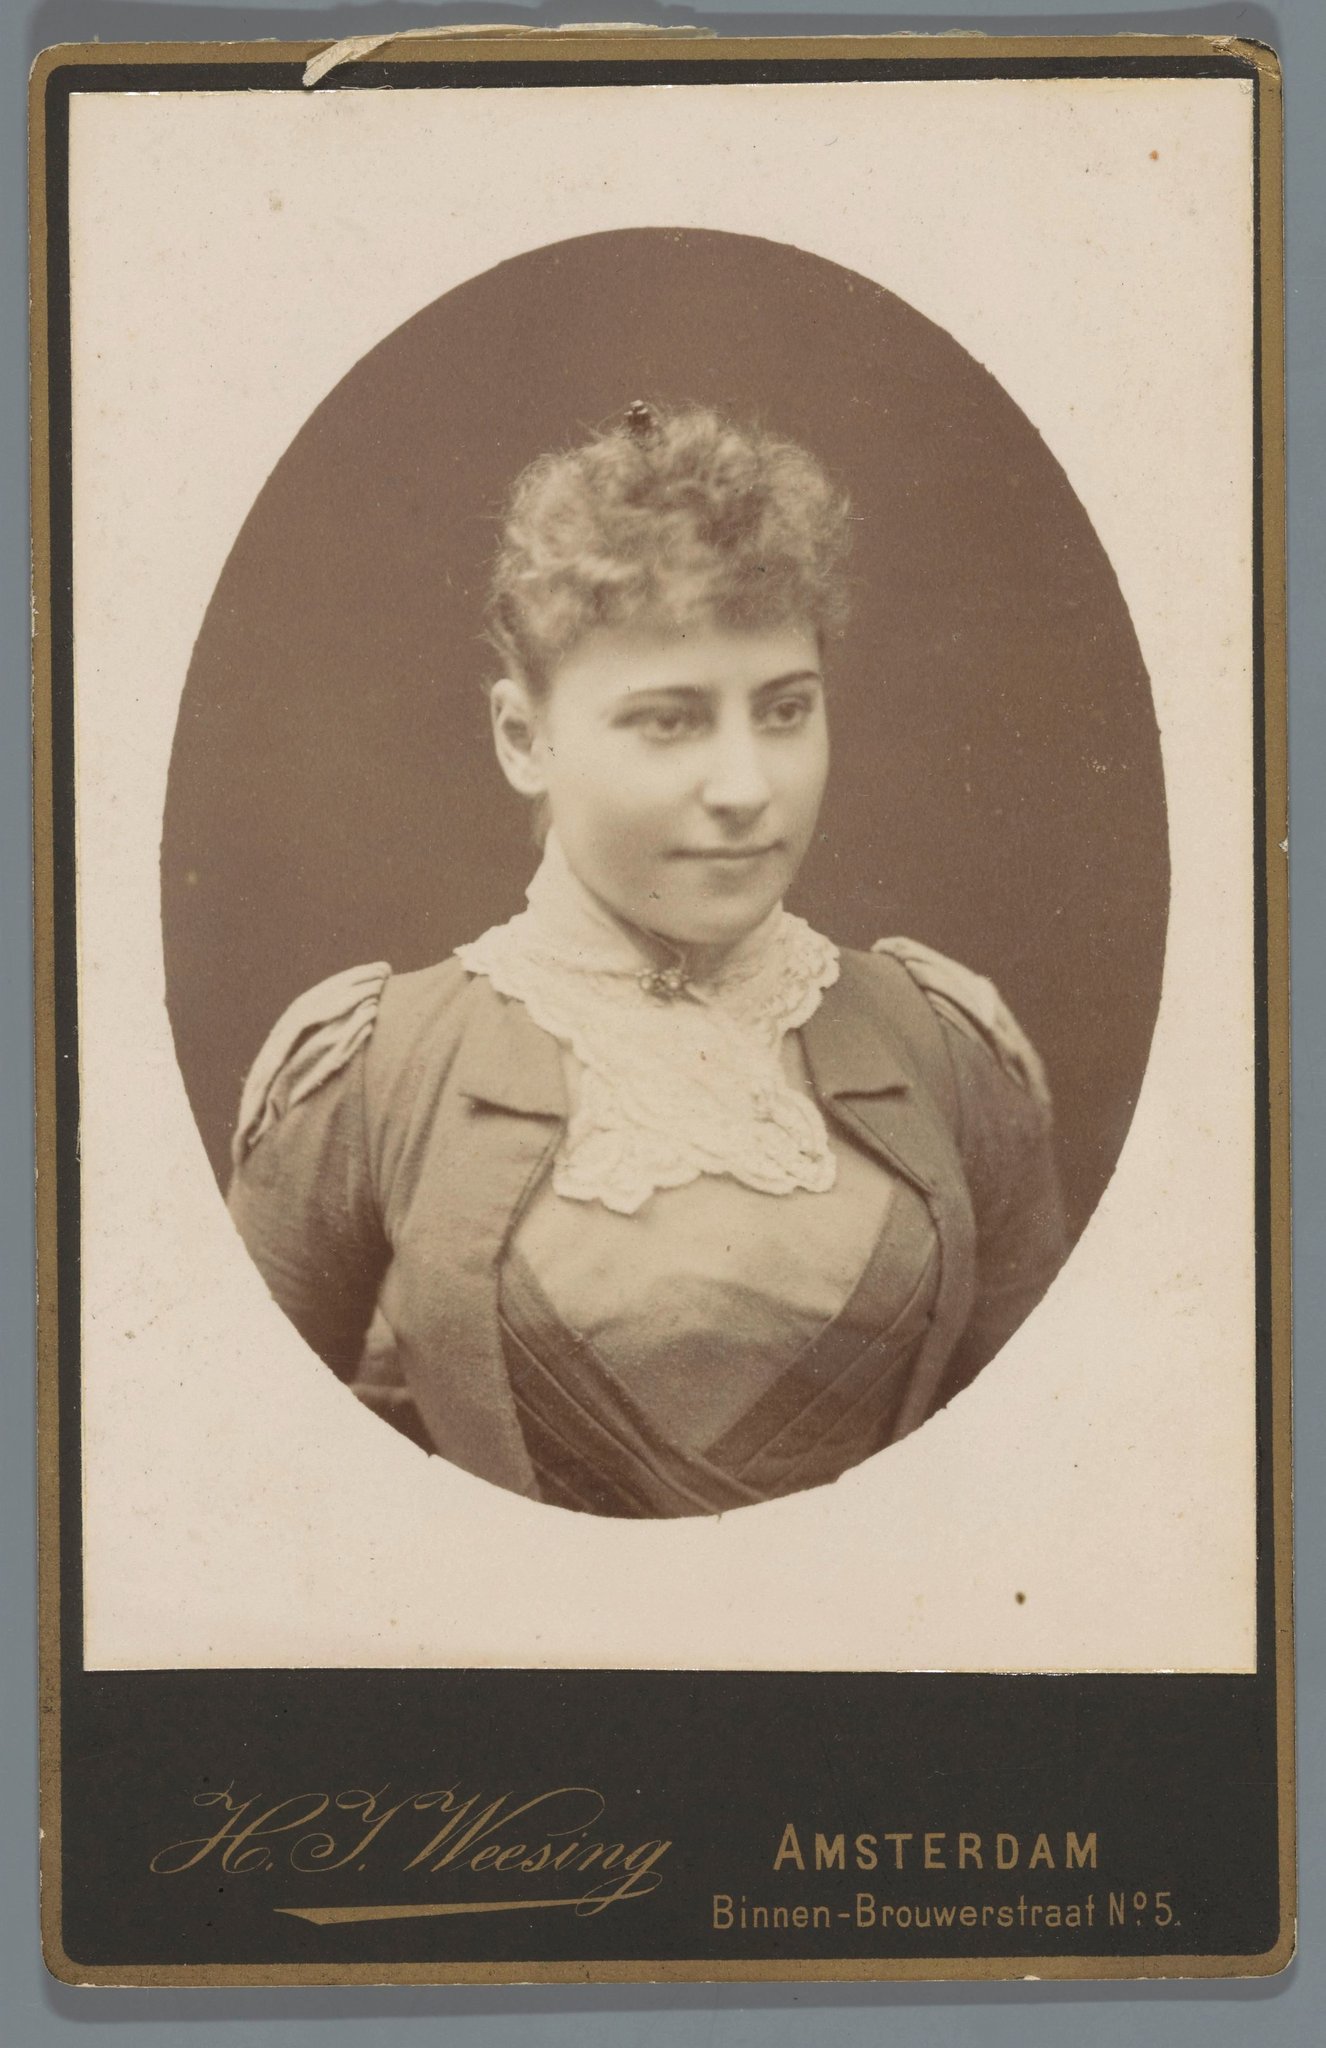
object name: cabinet photograph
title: Portret van een onbekende vrouw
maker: hermanus jodocus weesing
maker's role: fotograaf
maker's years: 1844-1910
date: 1880-1900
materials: cardboard, photographic support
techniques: albumen print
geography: amsterdam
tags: adult woman